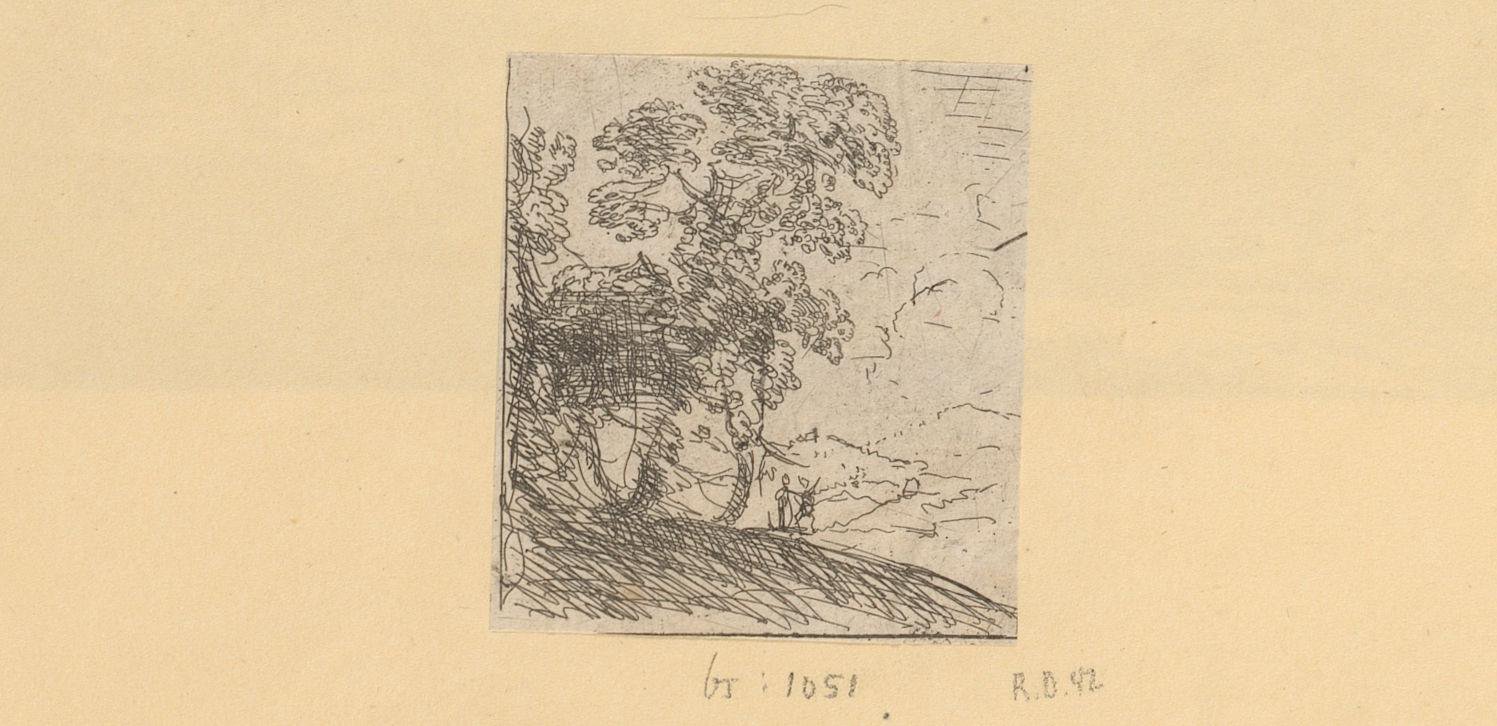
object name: print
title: Boom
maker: claude lorrain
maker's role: draughtsman, print maker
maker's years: 1604-1682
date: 1628-1632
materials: paper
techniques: etching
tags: trees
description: Prent maakt mogelijk deel uit van een serie van 200 prenten. Deze serie is onder de titel 'A Collection of two hundred original etchings' voor het eerst uitgegeven door J.M. Greery in 1816.